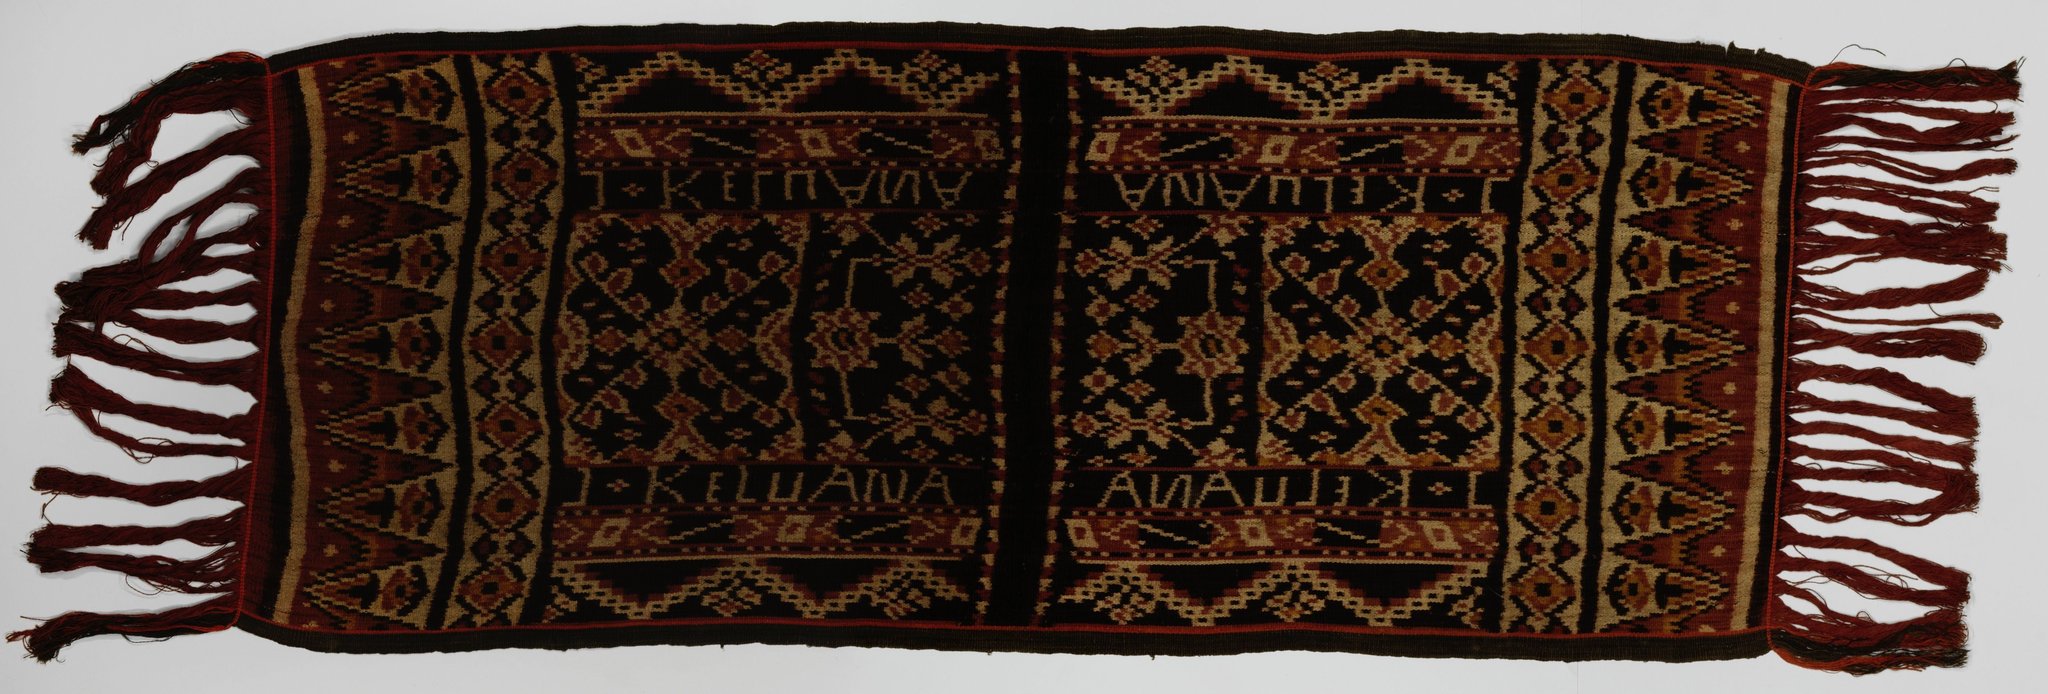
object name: cloth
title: Doek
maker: Anonymous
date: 1900-1949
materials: cotton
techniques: weave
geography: roti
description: In de Zuidwest Molukken en in Nusa Tenggara is de ikat een algemeen toegepaste weeftechniek. De kleuren zijn overwegend donkerbruin, donkerblauw en wit. De doeken geven de status van de drager aan en zijn in gebruik als geschenken tussen de familie van de bruid en bruidegom.